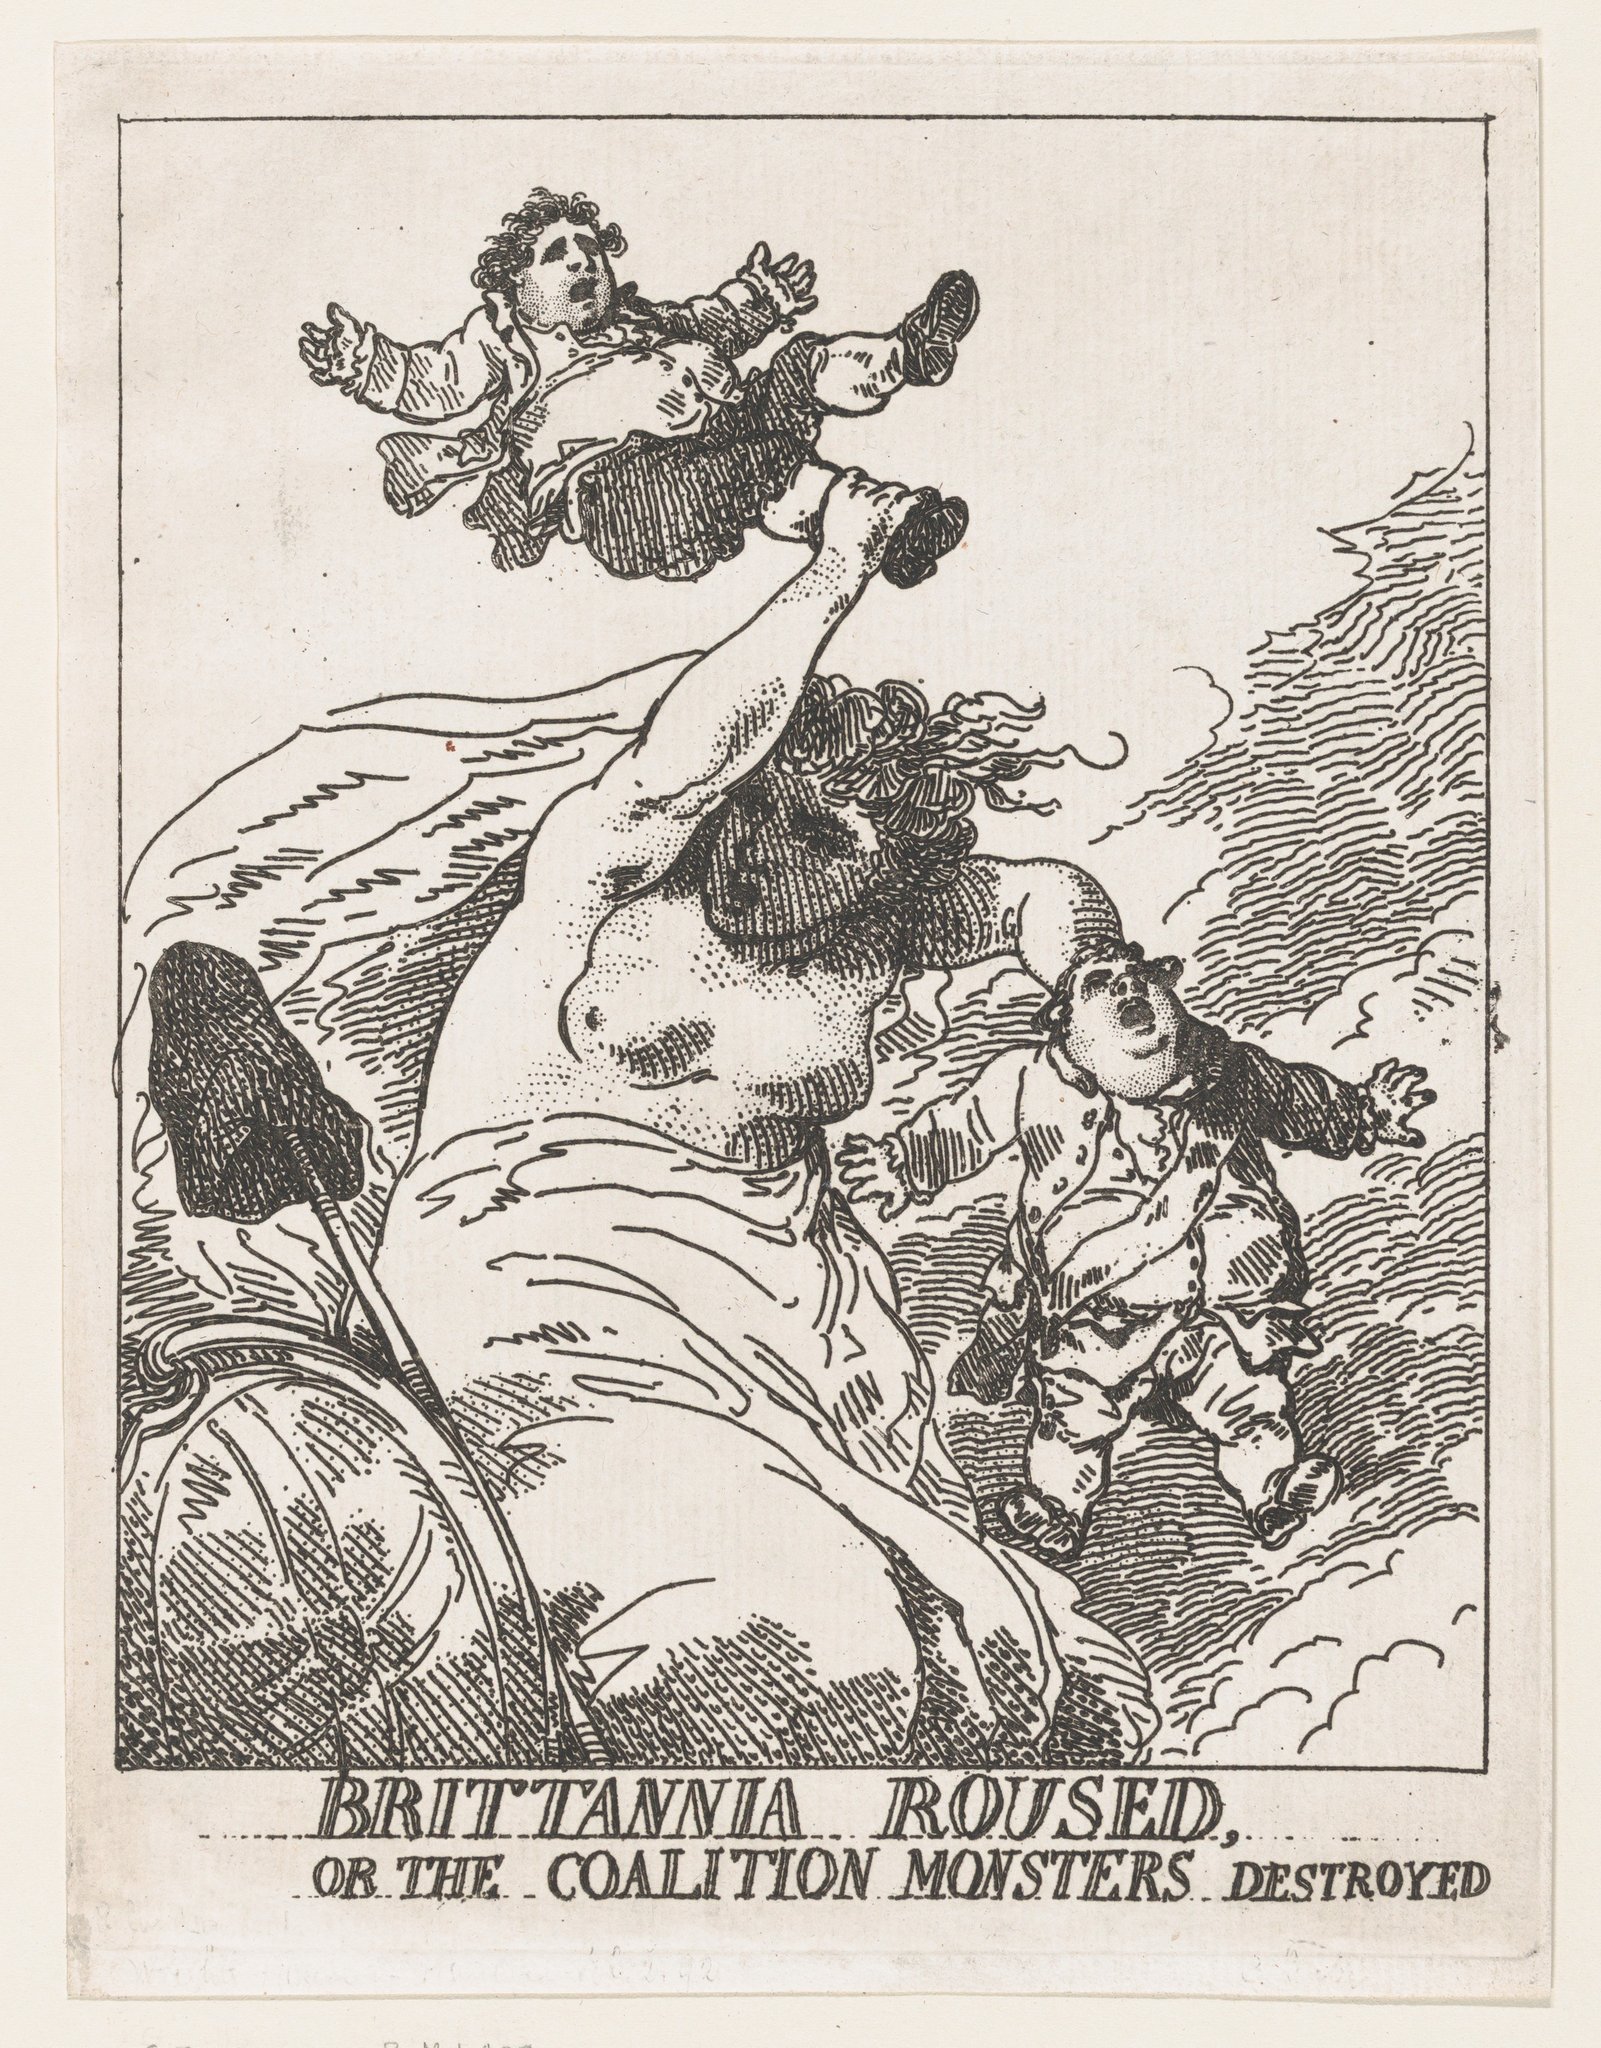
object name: print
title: Britannia Roused, or the Coalition Monsters Destroyed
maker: thomas rowlandson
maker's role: artist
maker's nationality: british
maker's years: 1757-1827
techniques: etching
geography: london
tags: satire,men,female nudes,politics